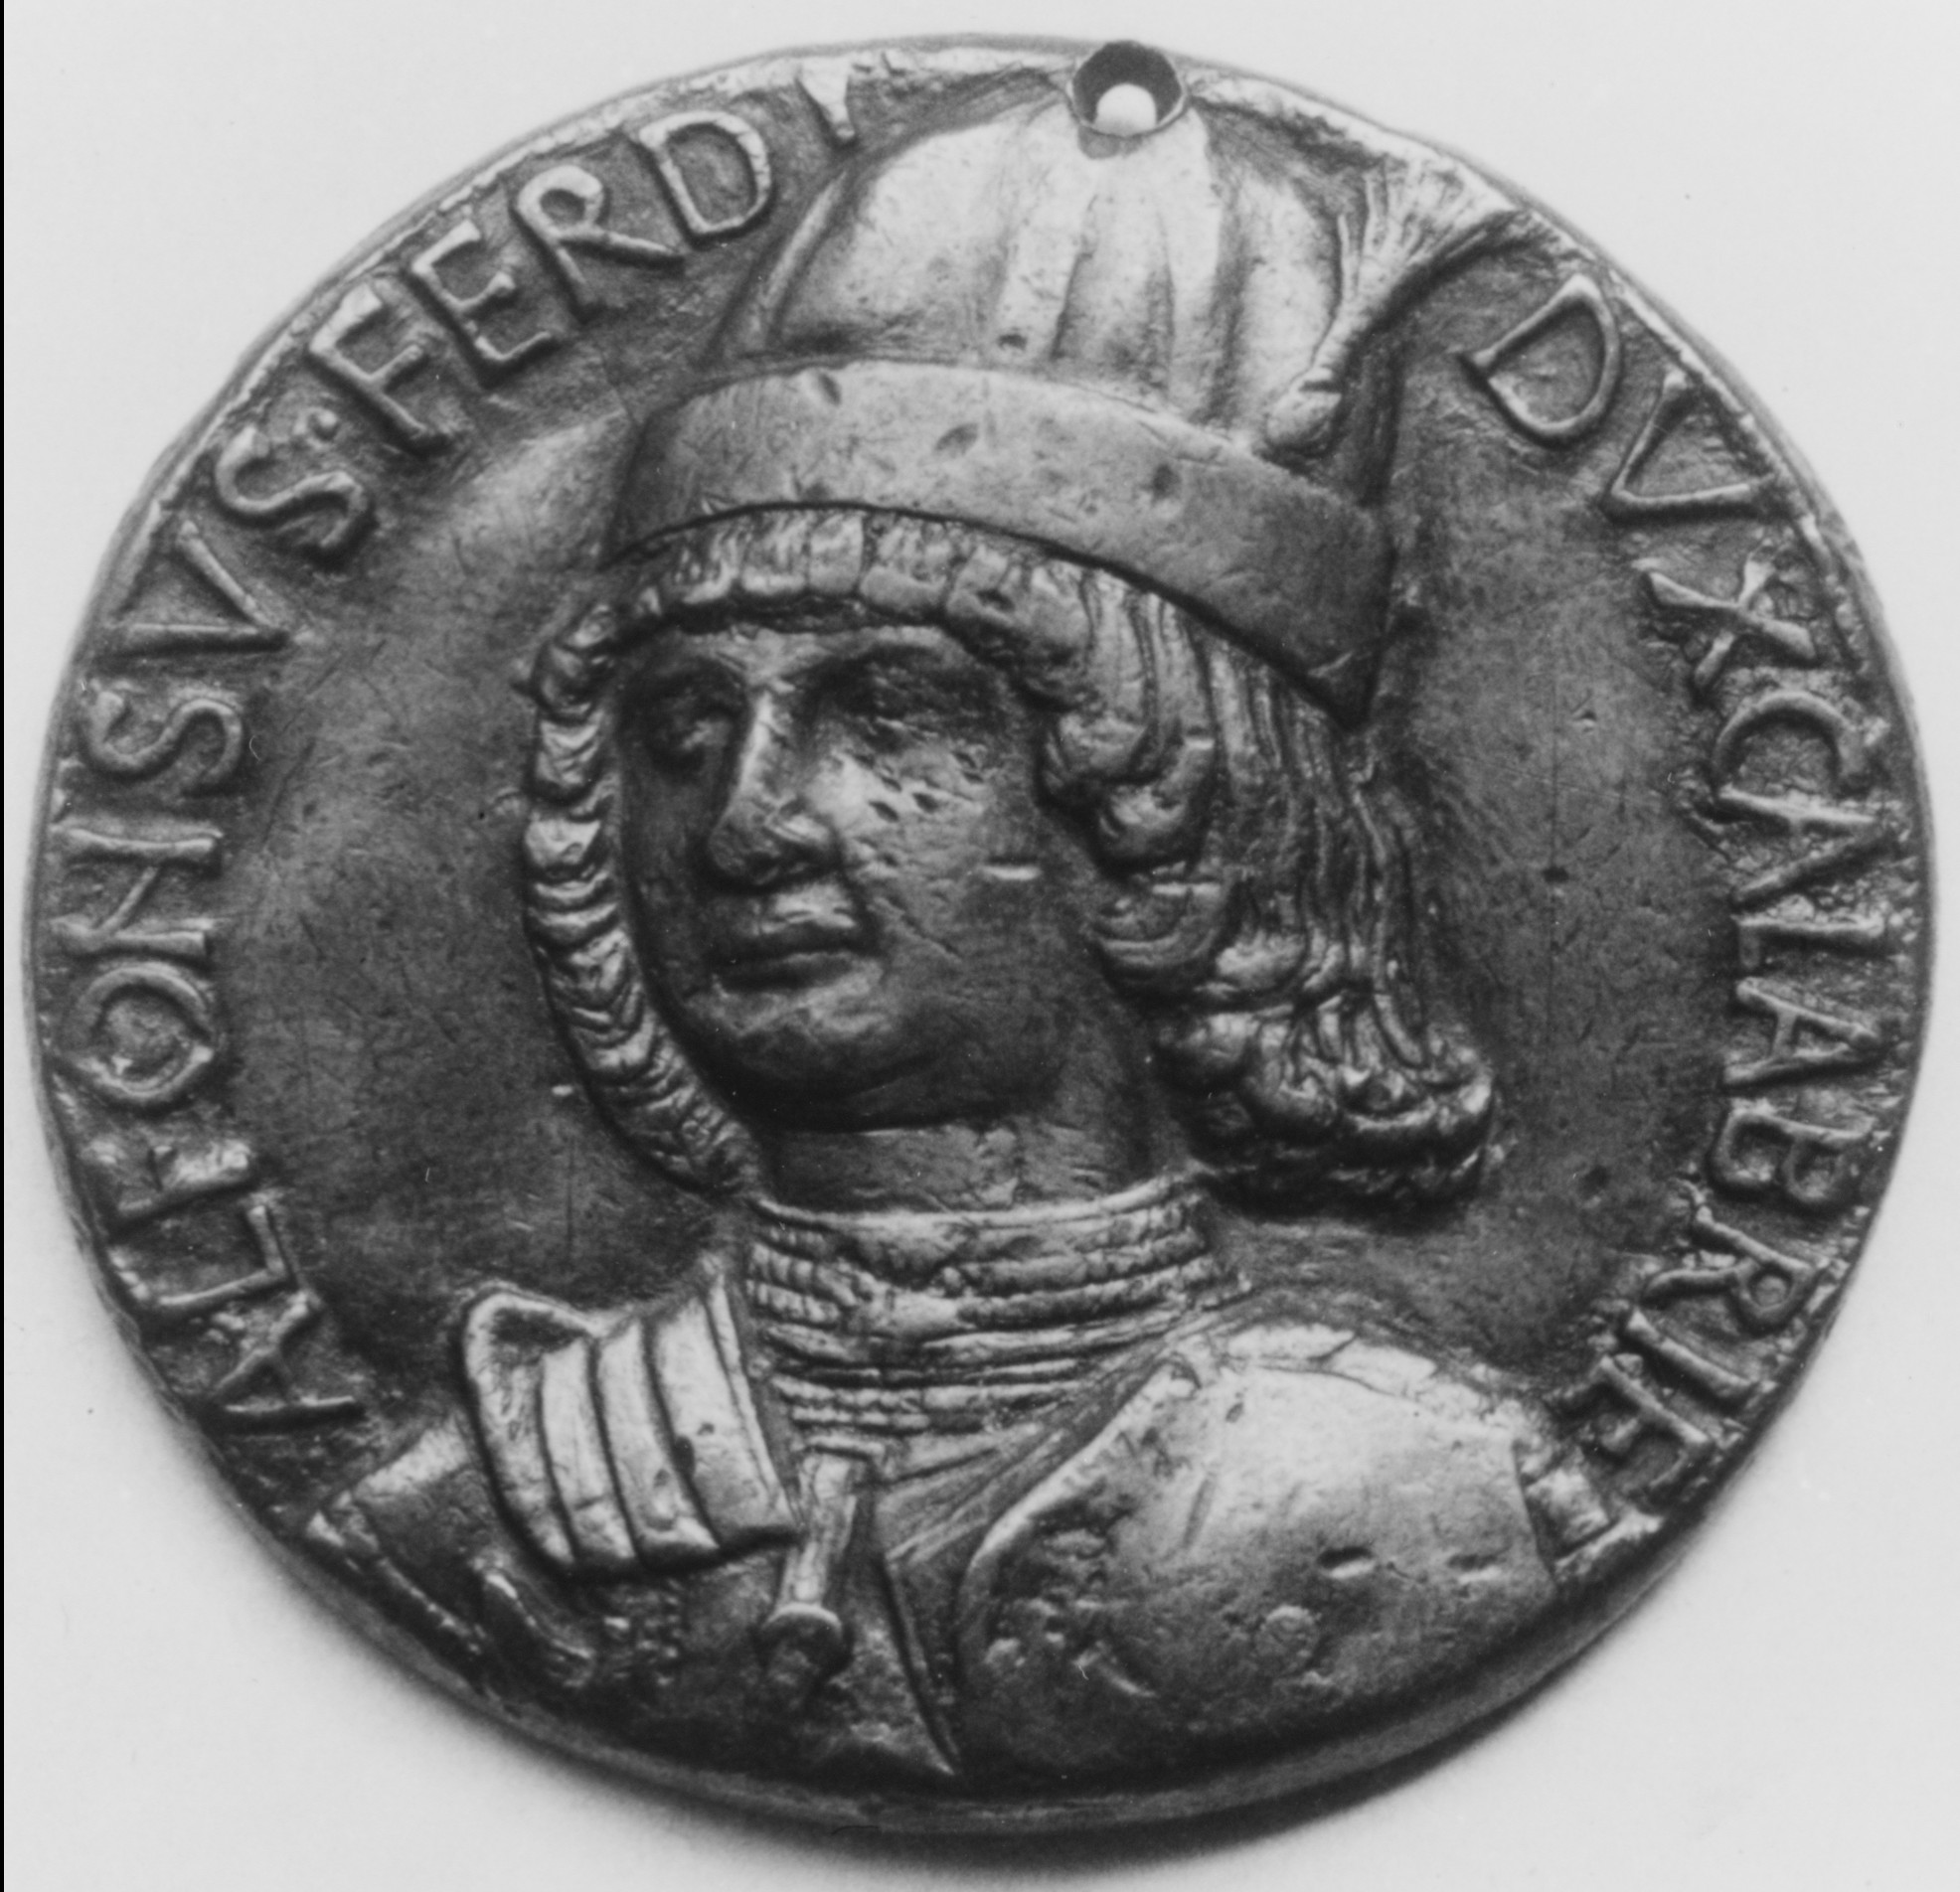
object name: medal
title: Alfonso of Aragon, Duke of Calabria (1448–1495)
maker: andrea guazzalotti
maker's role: artist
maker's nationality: italian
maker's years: 1435-1495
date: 1481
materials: bronze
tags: human figures,men,portraits,horses